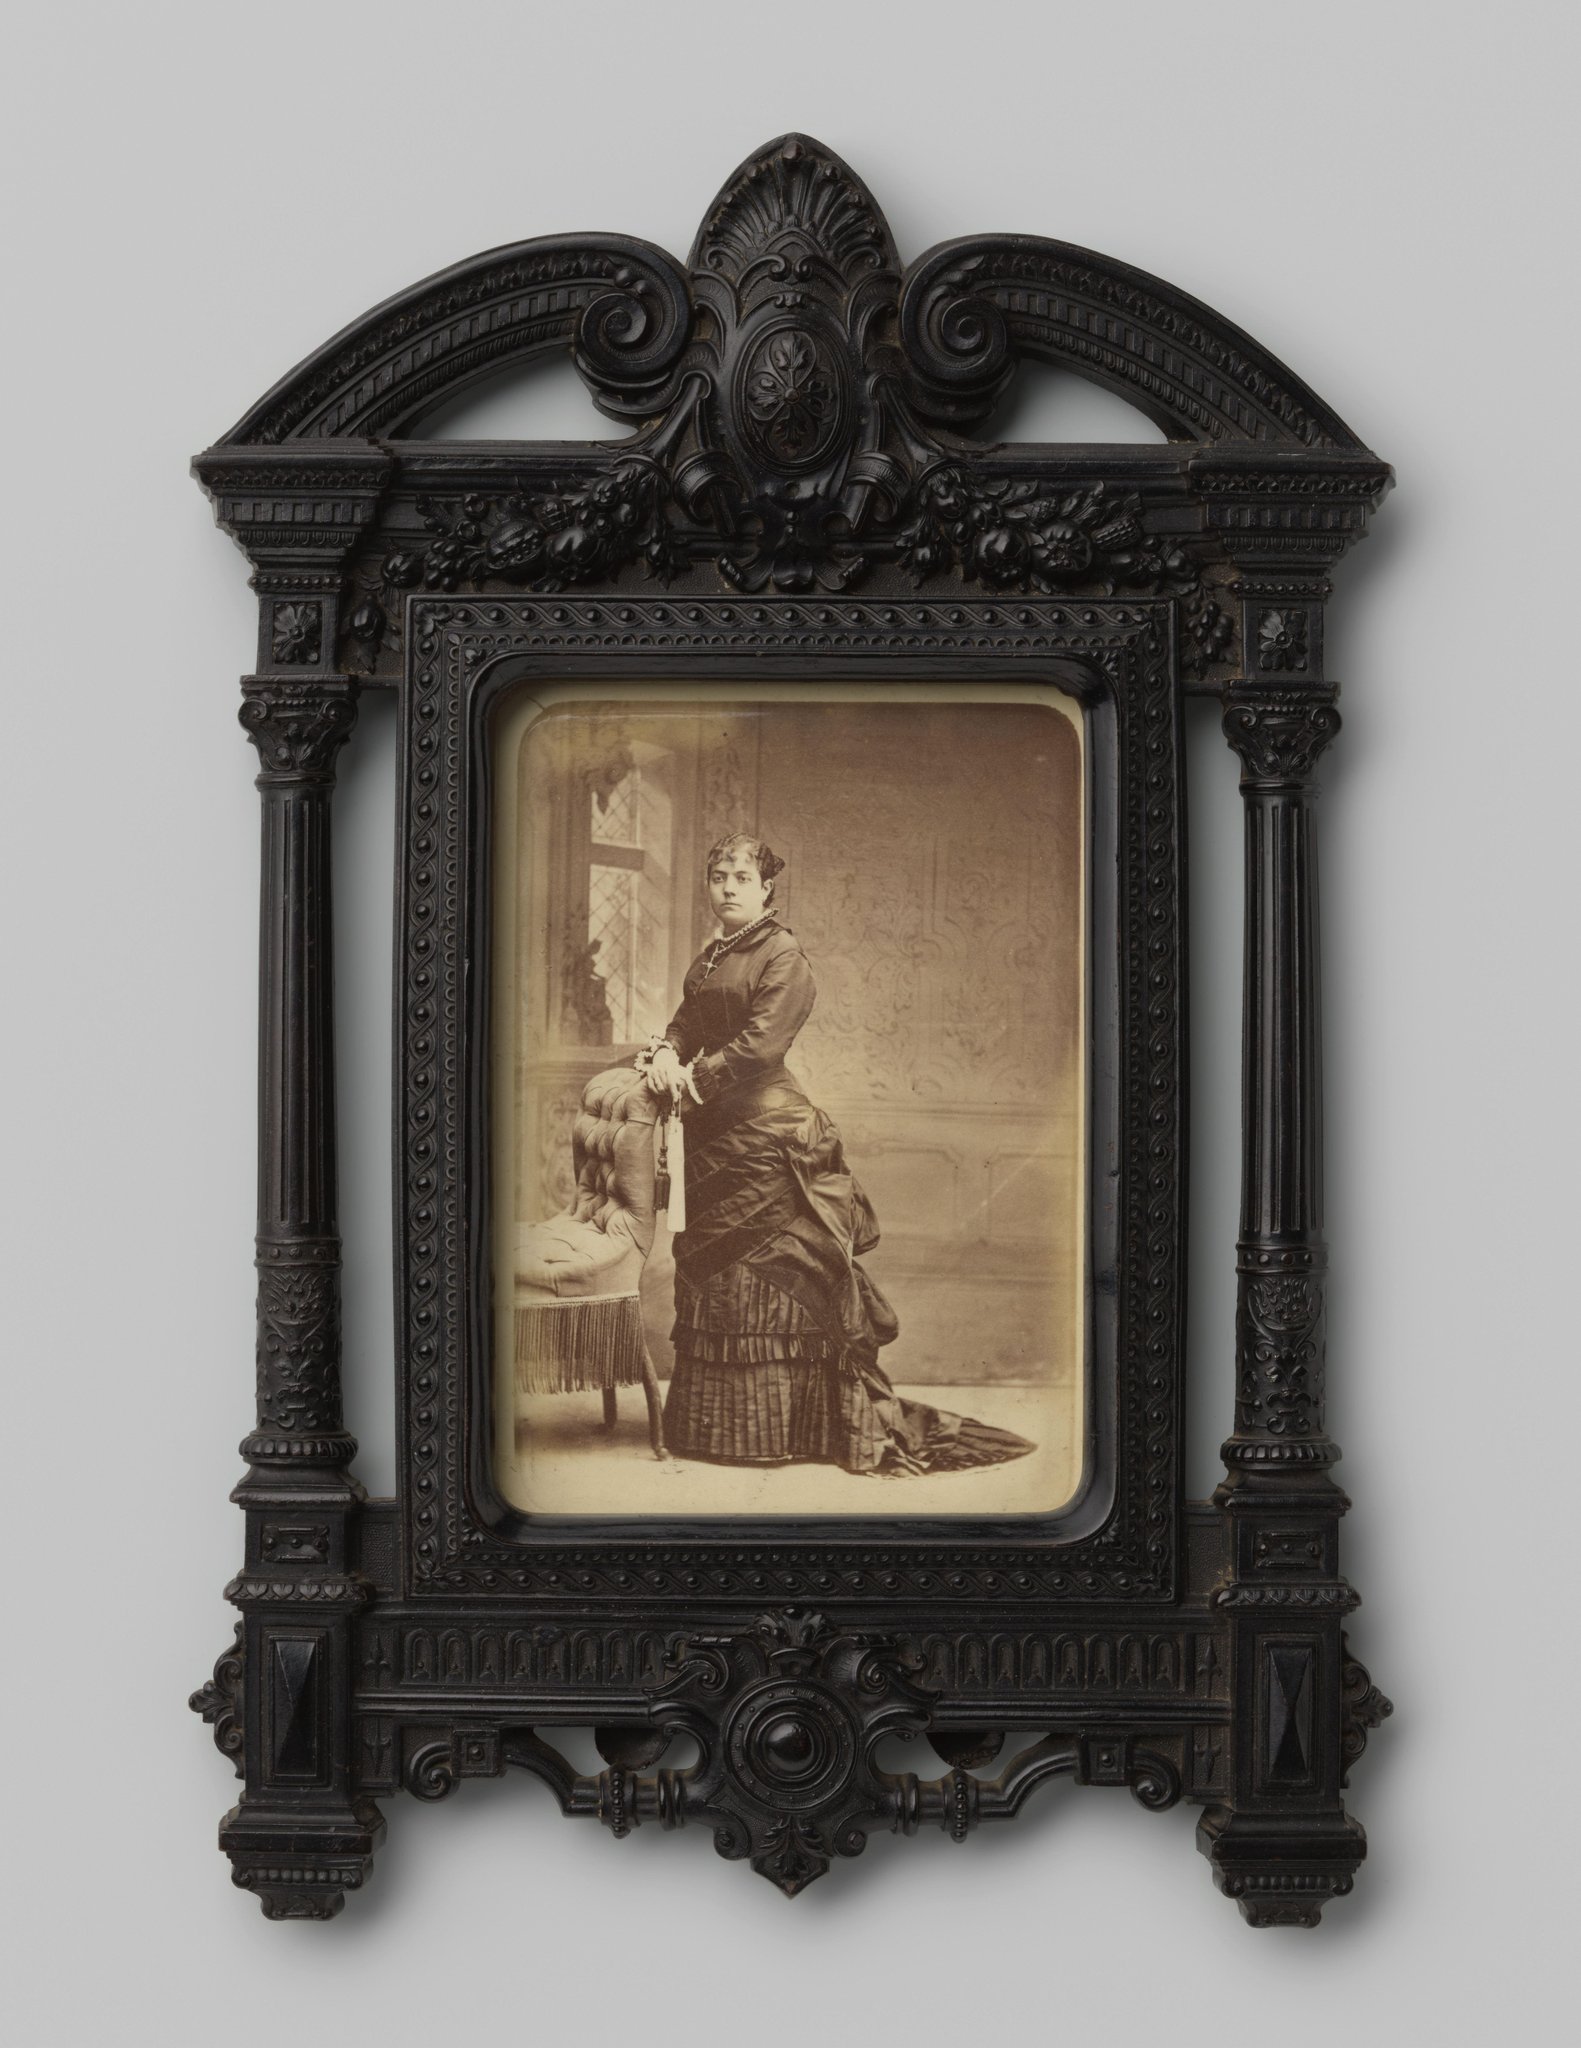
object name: frame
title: Portret van een onbekende staande vrouw bij een stoel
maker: Anonymous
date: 1880-1890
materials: cardboard, glass, metal, paper, wood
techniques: albumen print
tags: adult woman, anonymous historical person portrayed